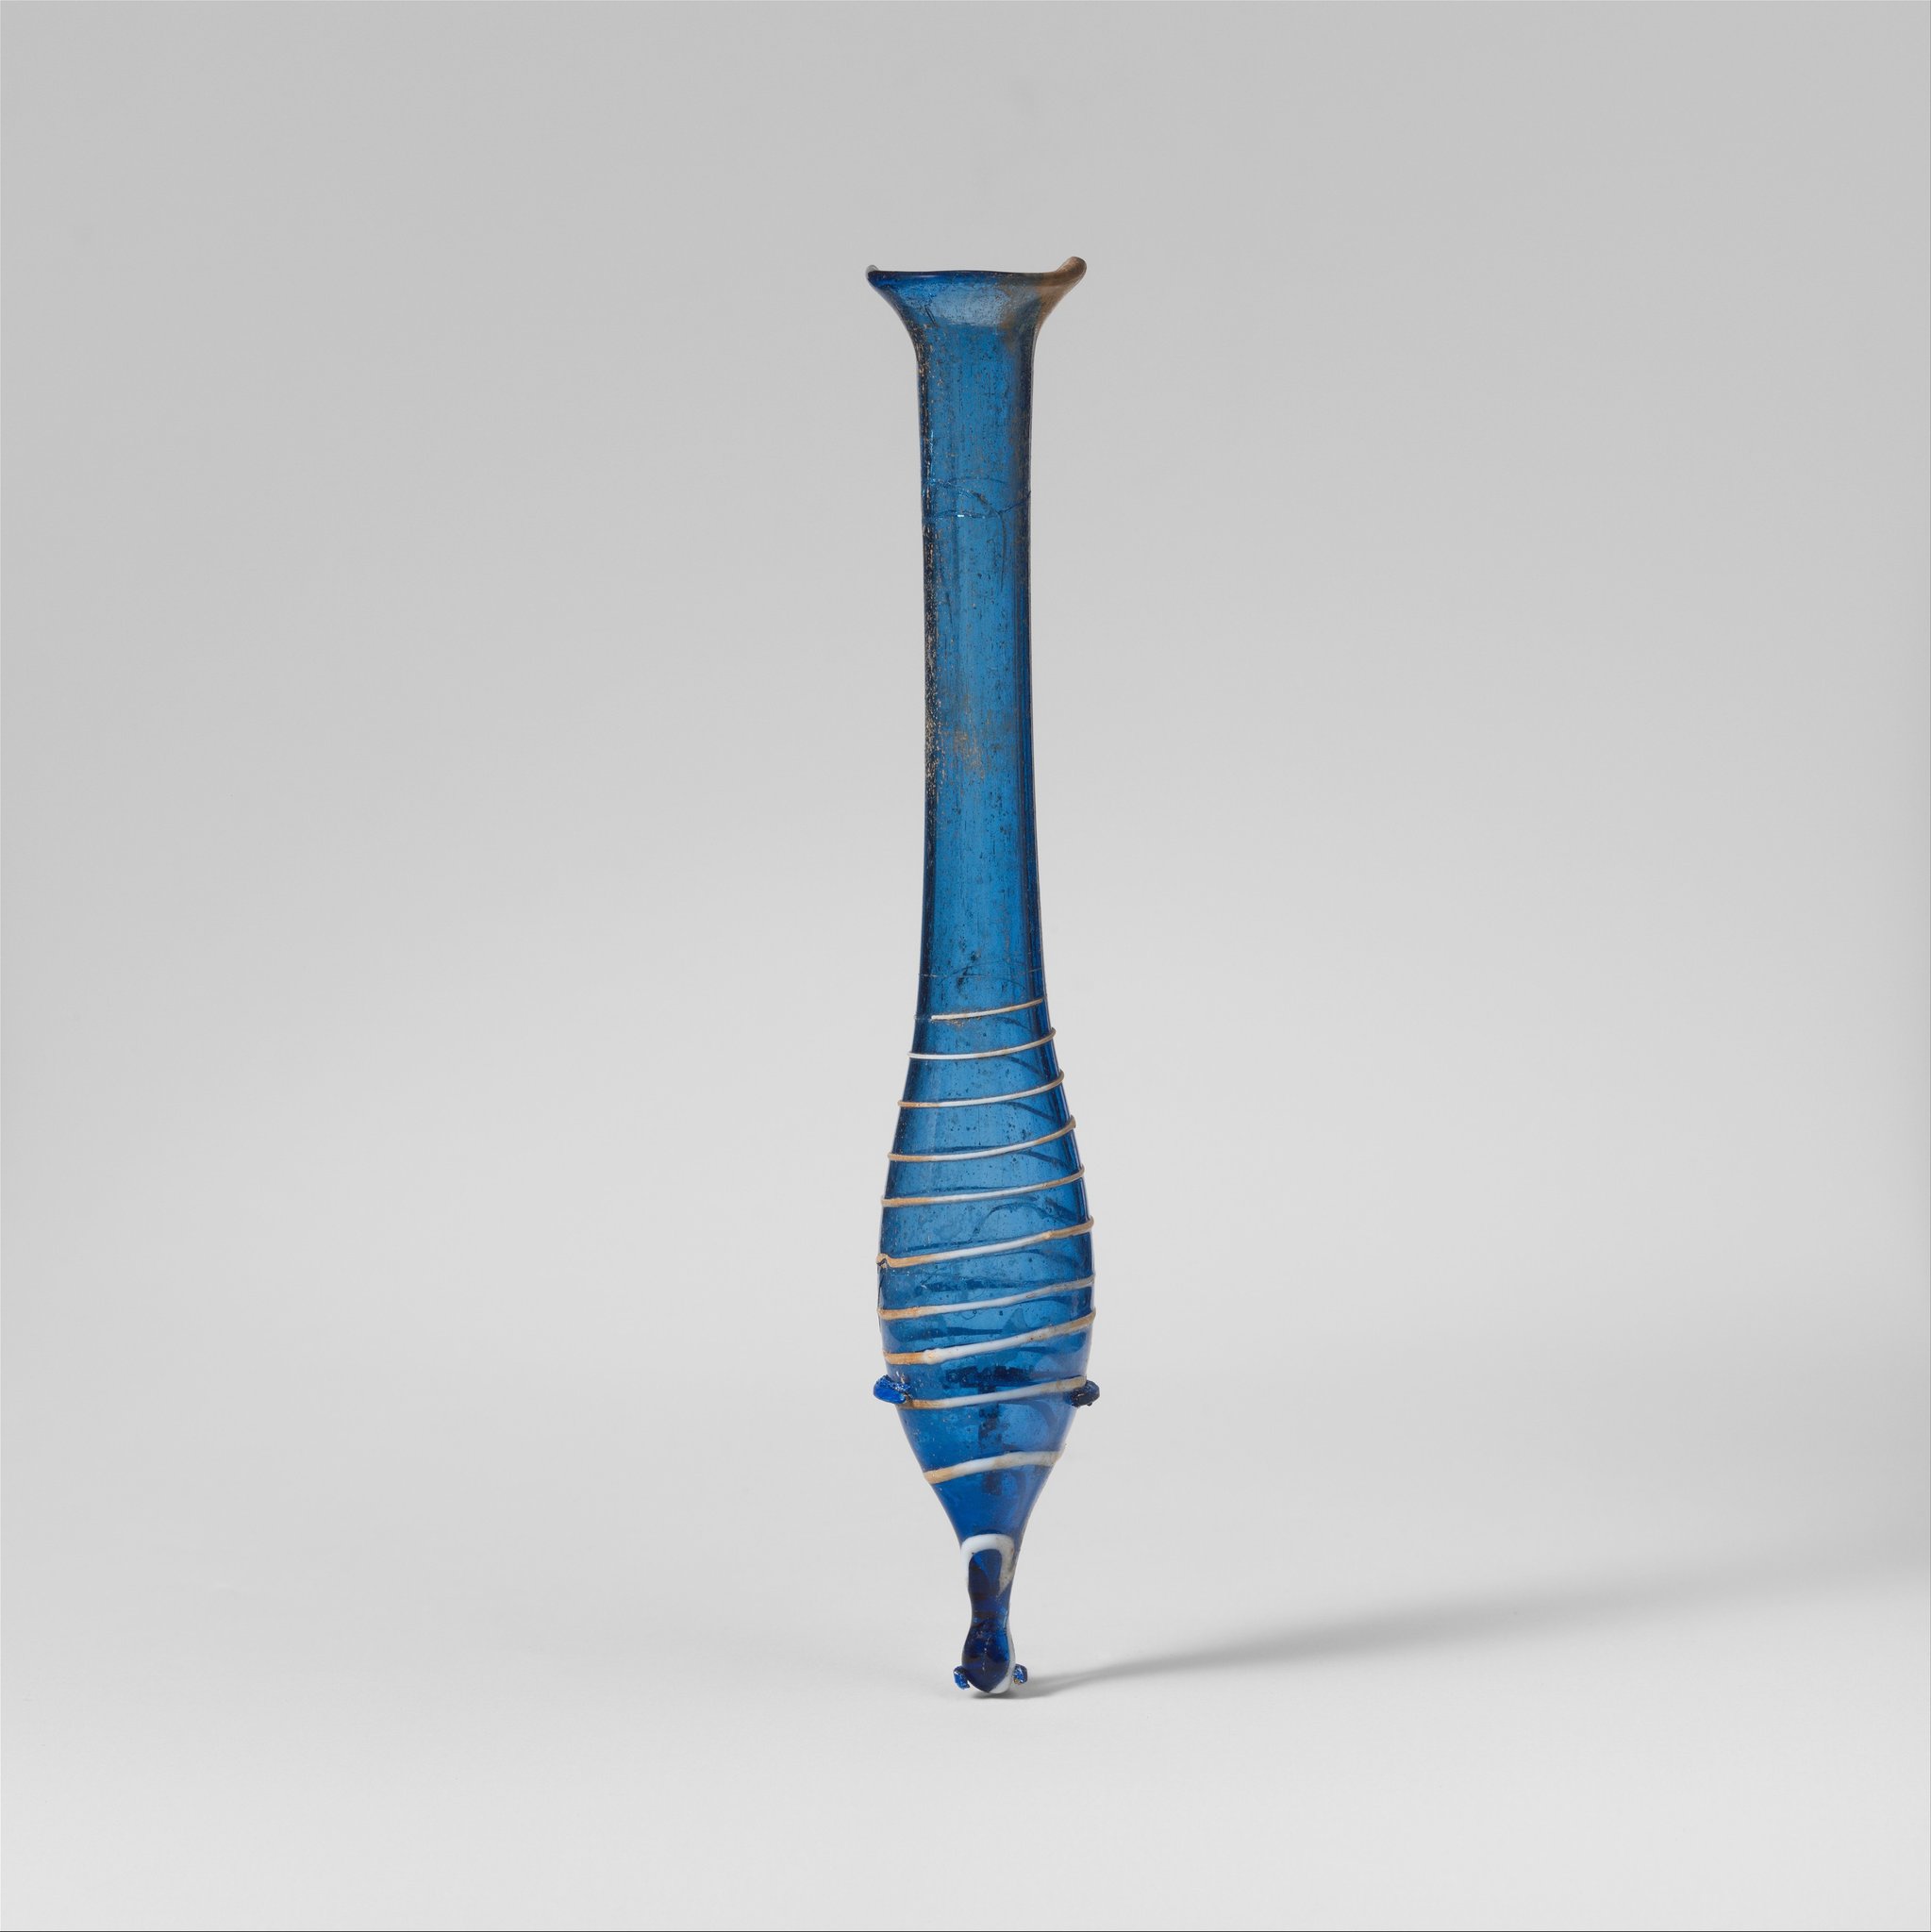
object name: perfume bottle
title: Glass perfume bottle with opaque white trail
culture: roman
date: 1-100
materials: glass